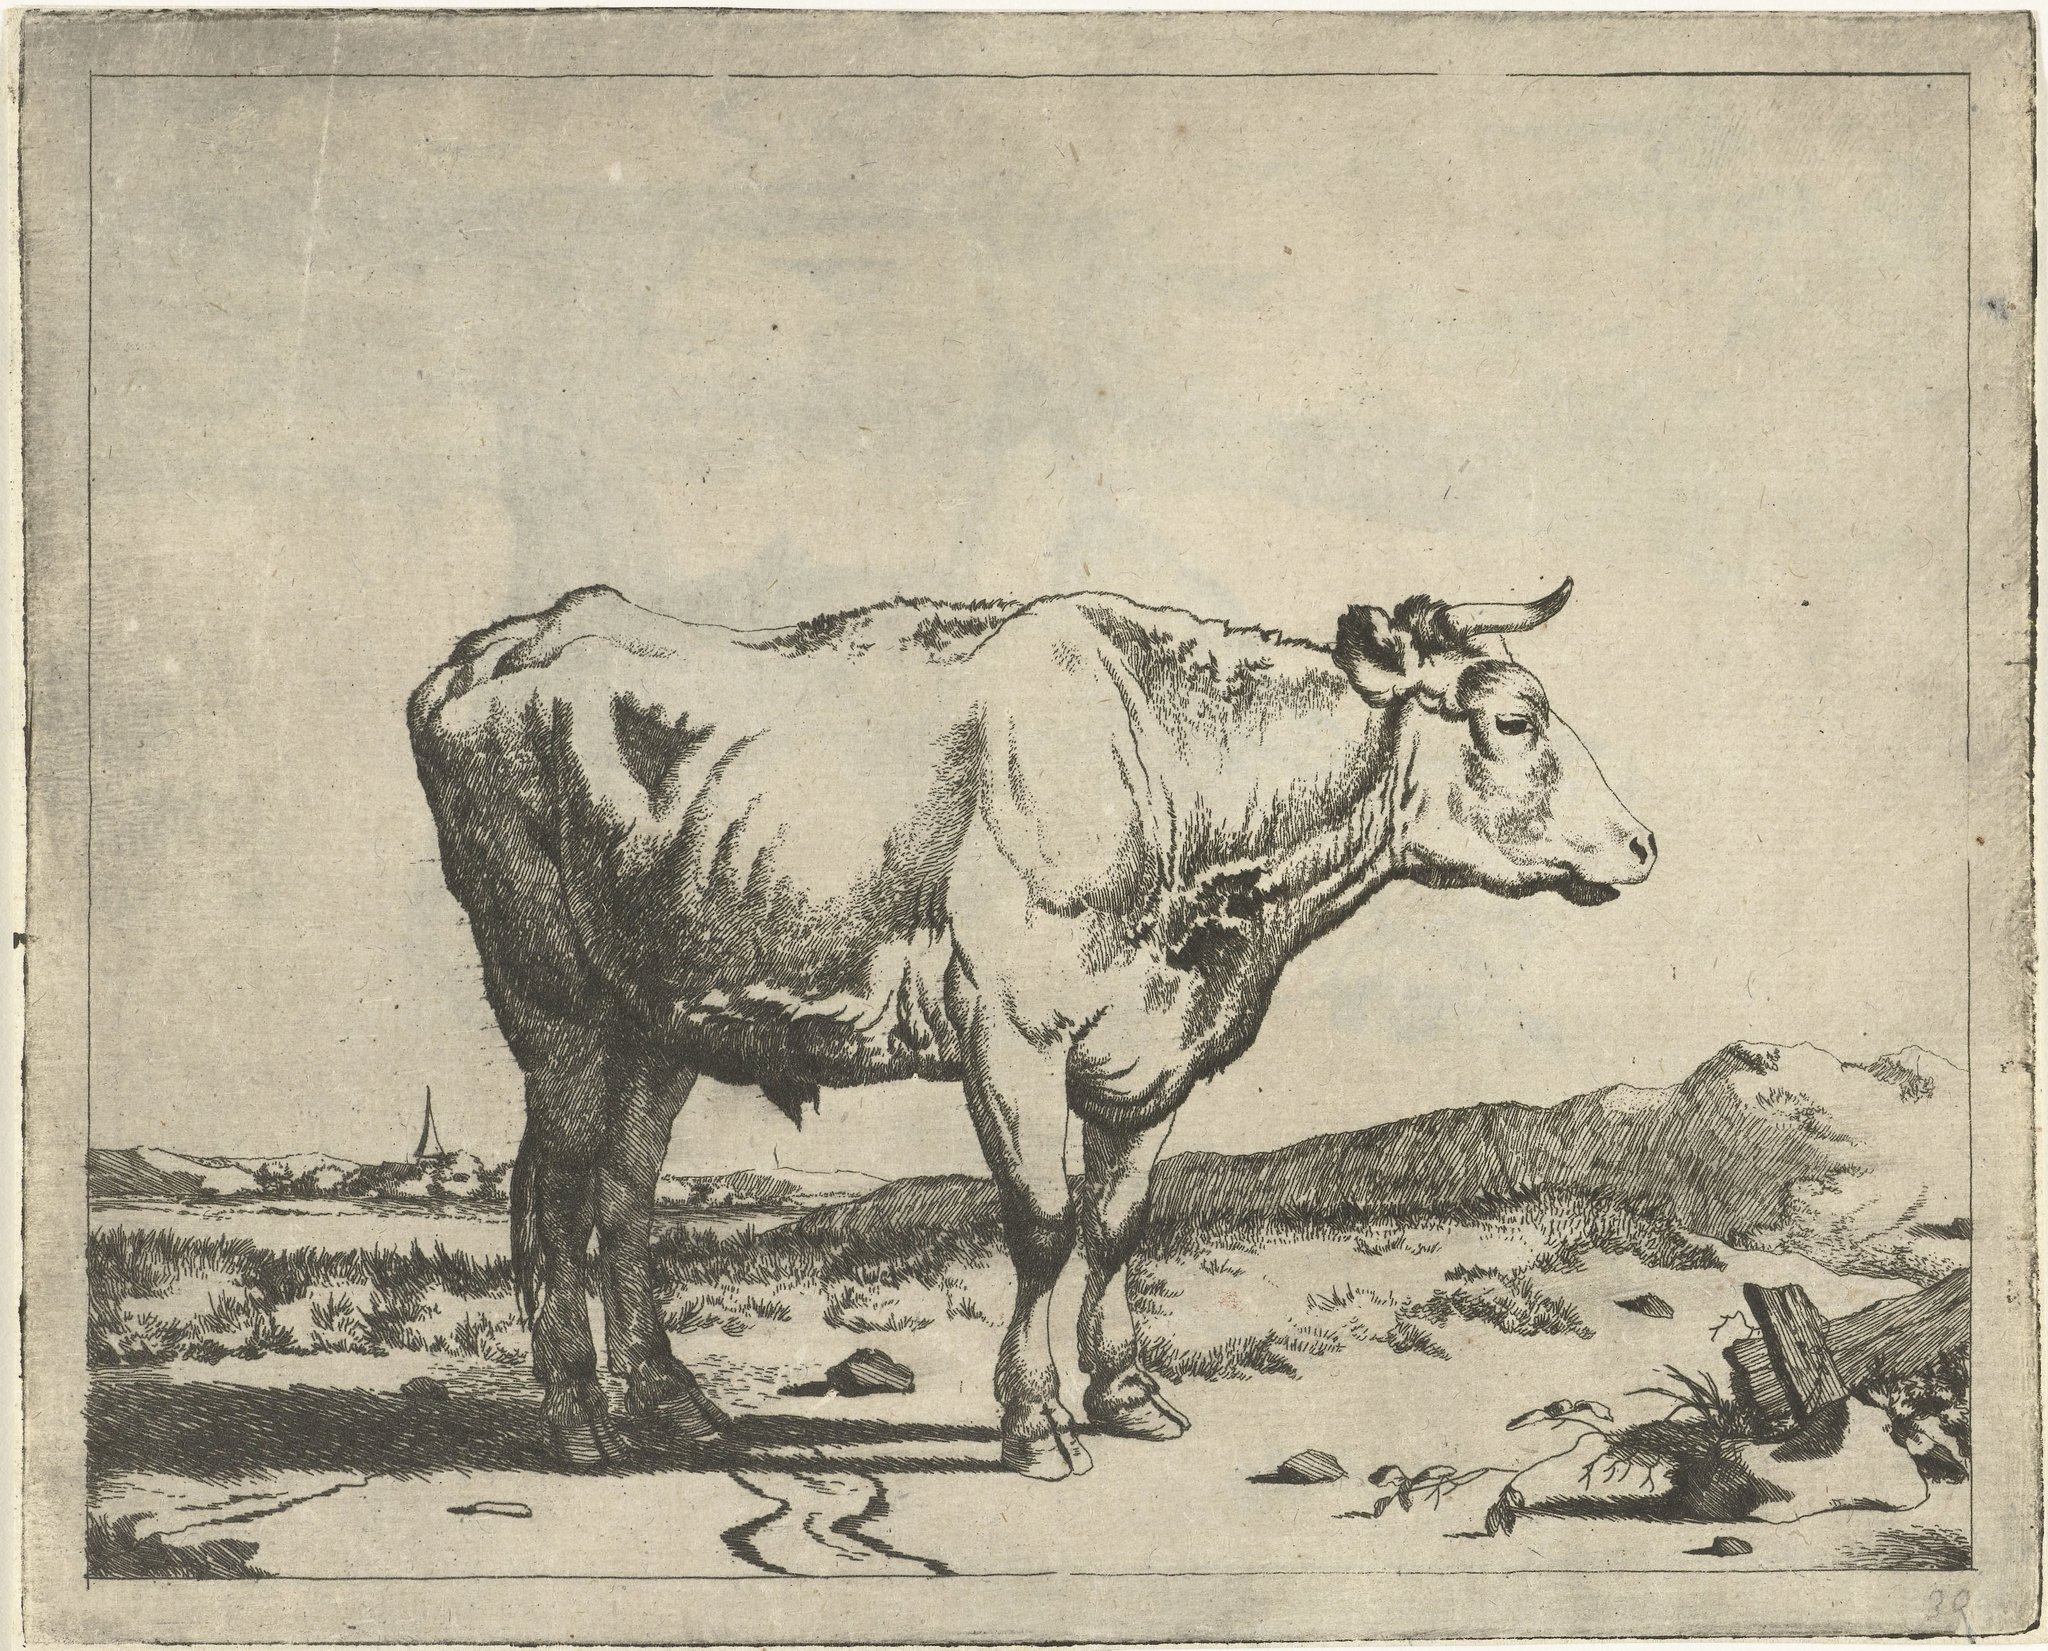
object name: print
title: Stier, naar rechts, met kerktoren op achtergrond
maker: marcus de bye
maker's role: print maker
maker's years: 1639-1688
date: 1649-1677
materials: paper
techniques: etching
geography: the hague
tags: cow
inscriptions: collector's mark: Lugt 240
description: Op verso zijde een afdruk van dezelfde voorstelling.